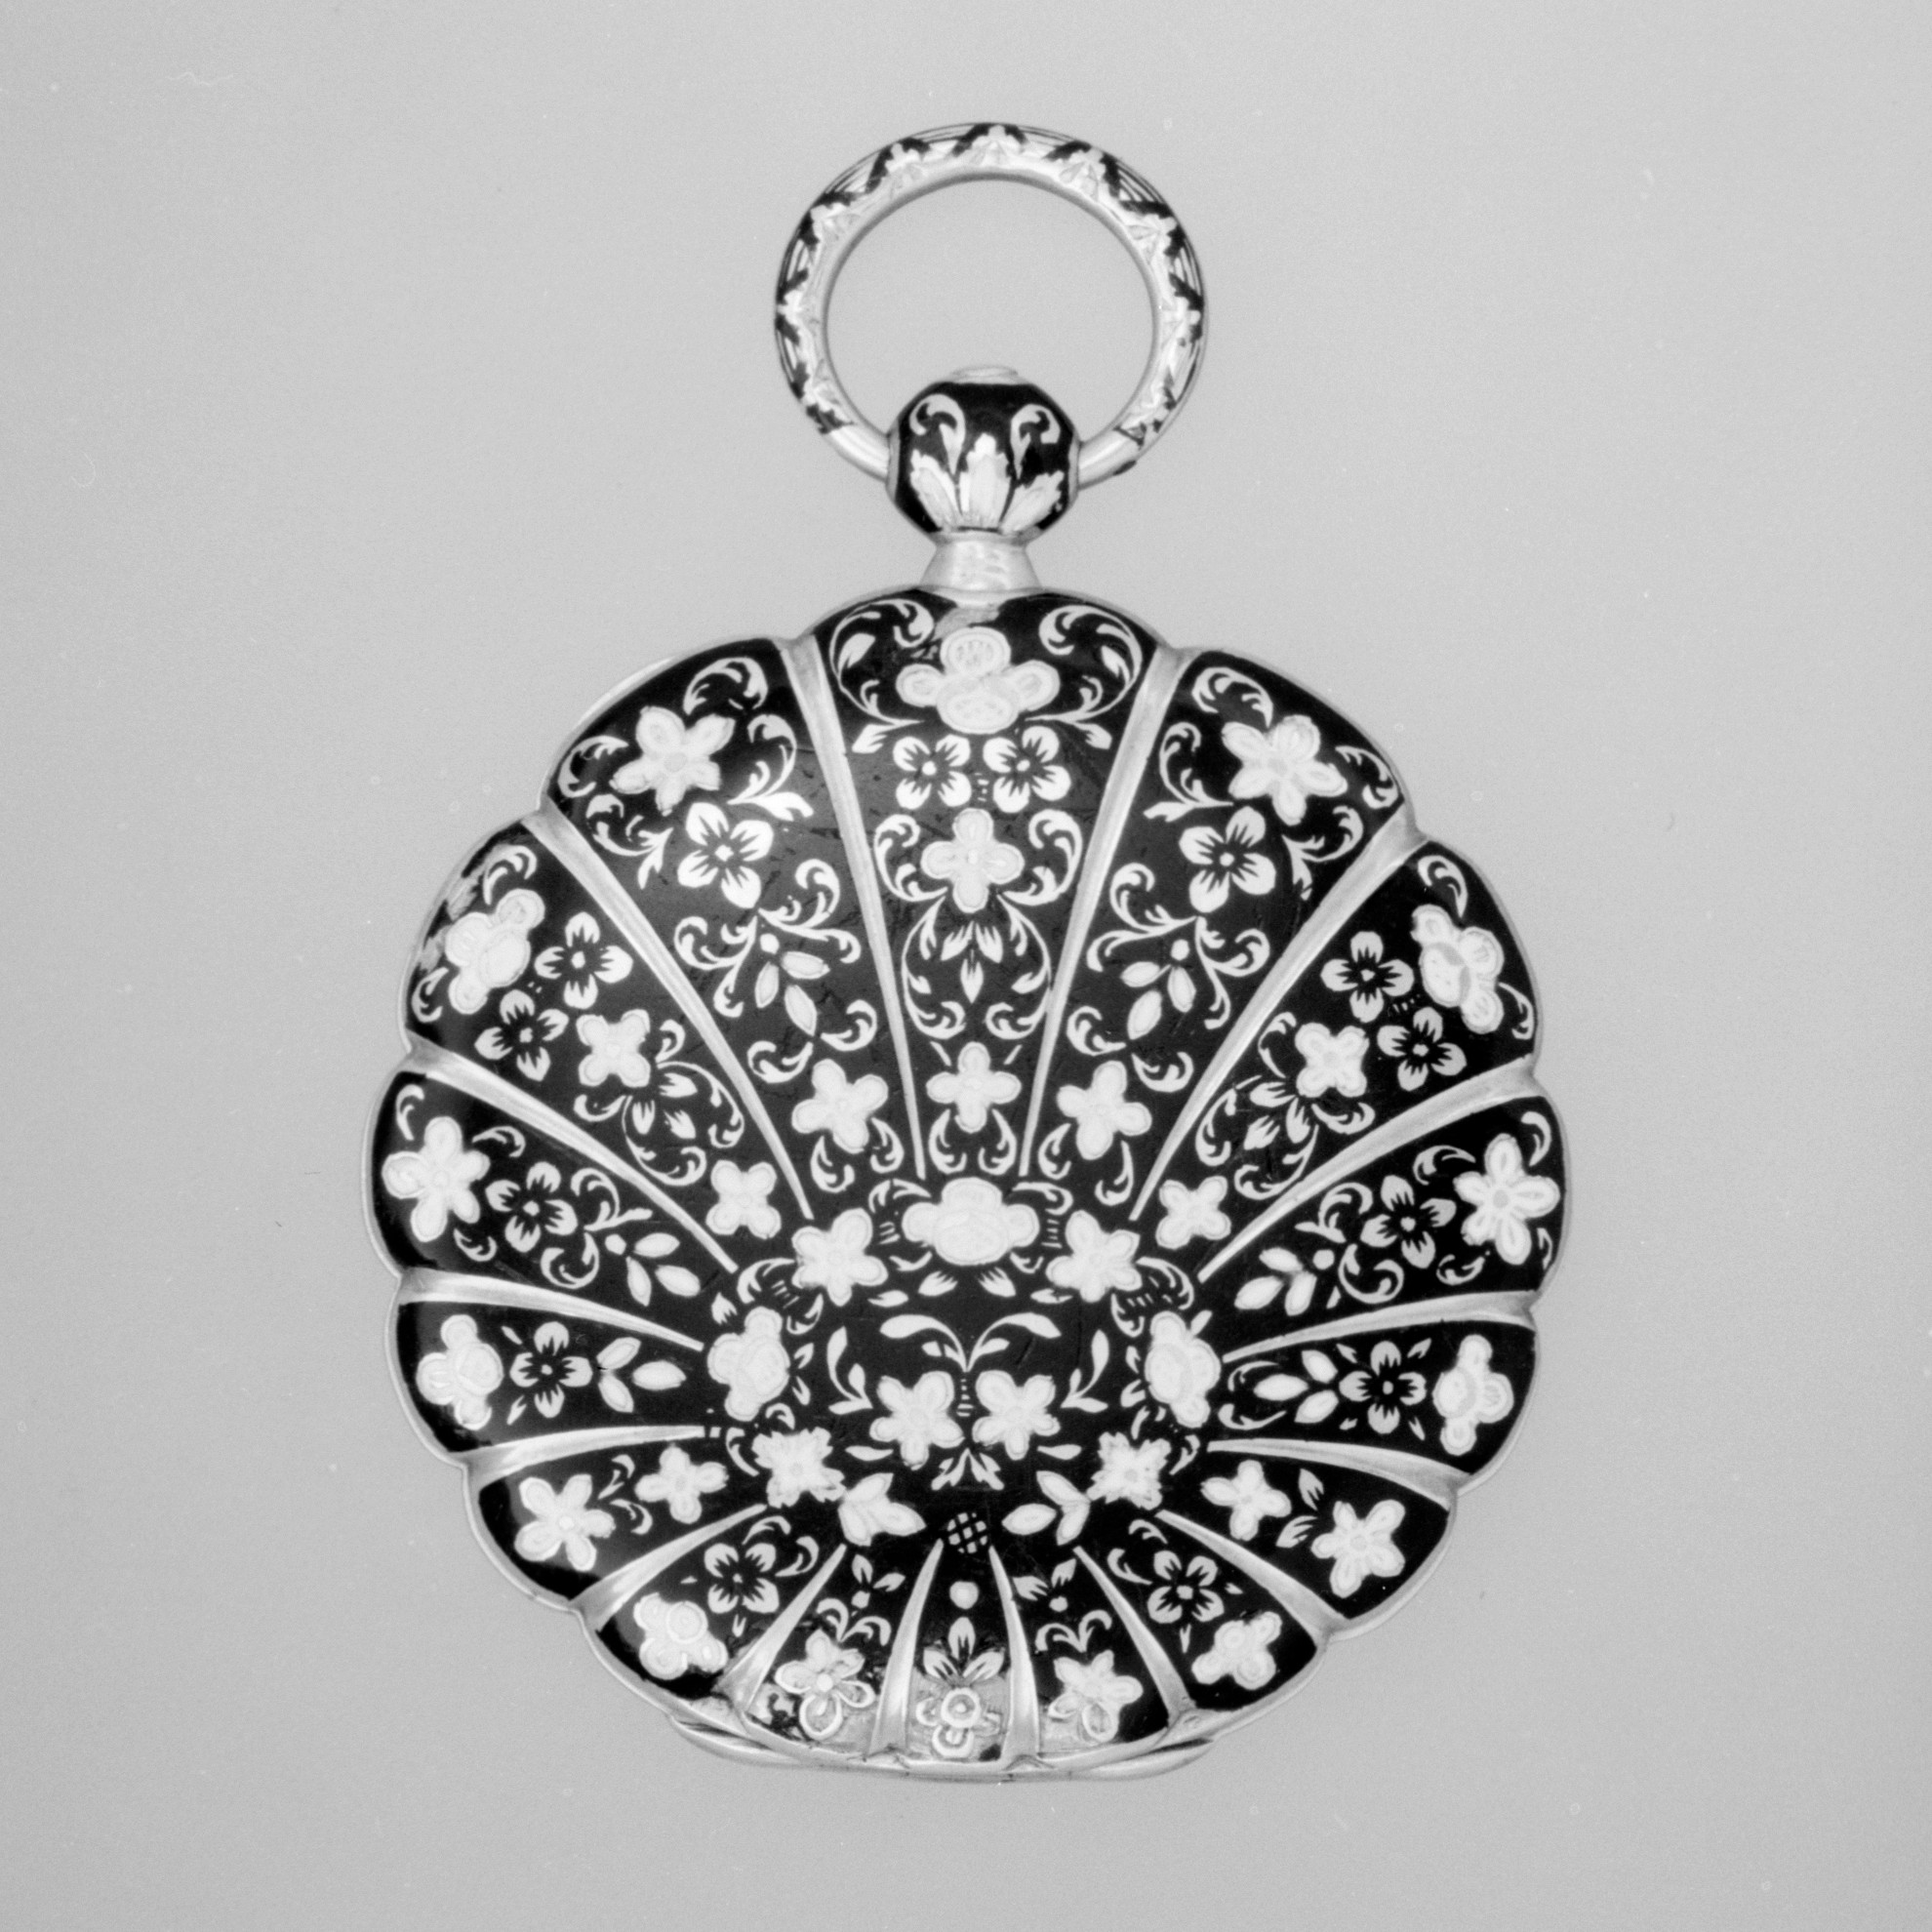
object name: watch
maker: jean-françois bautte & co.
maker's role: maker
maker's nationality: swiss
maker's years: 1837-1855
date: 1837-1855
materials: enamel, gold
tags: flowers,leaves